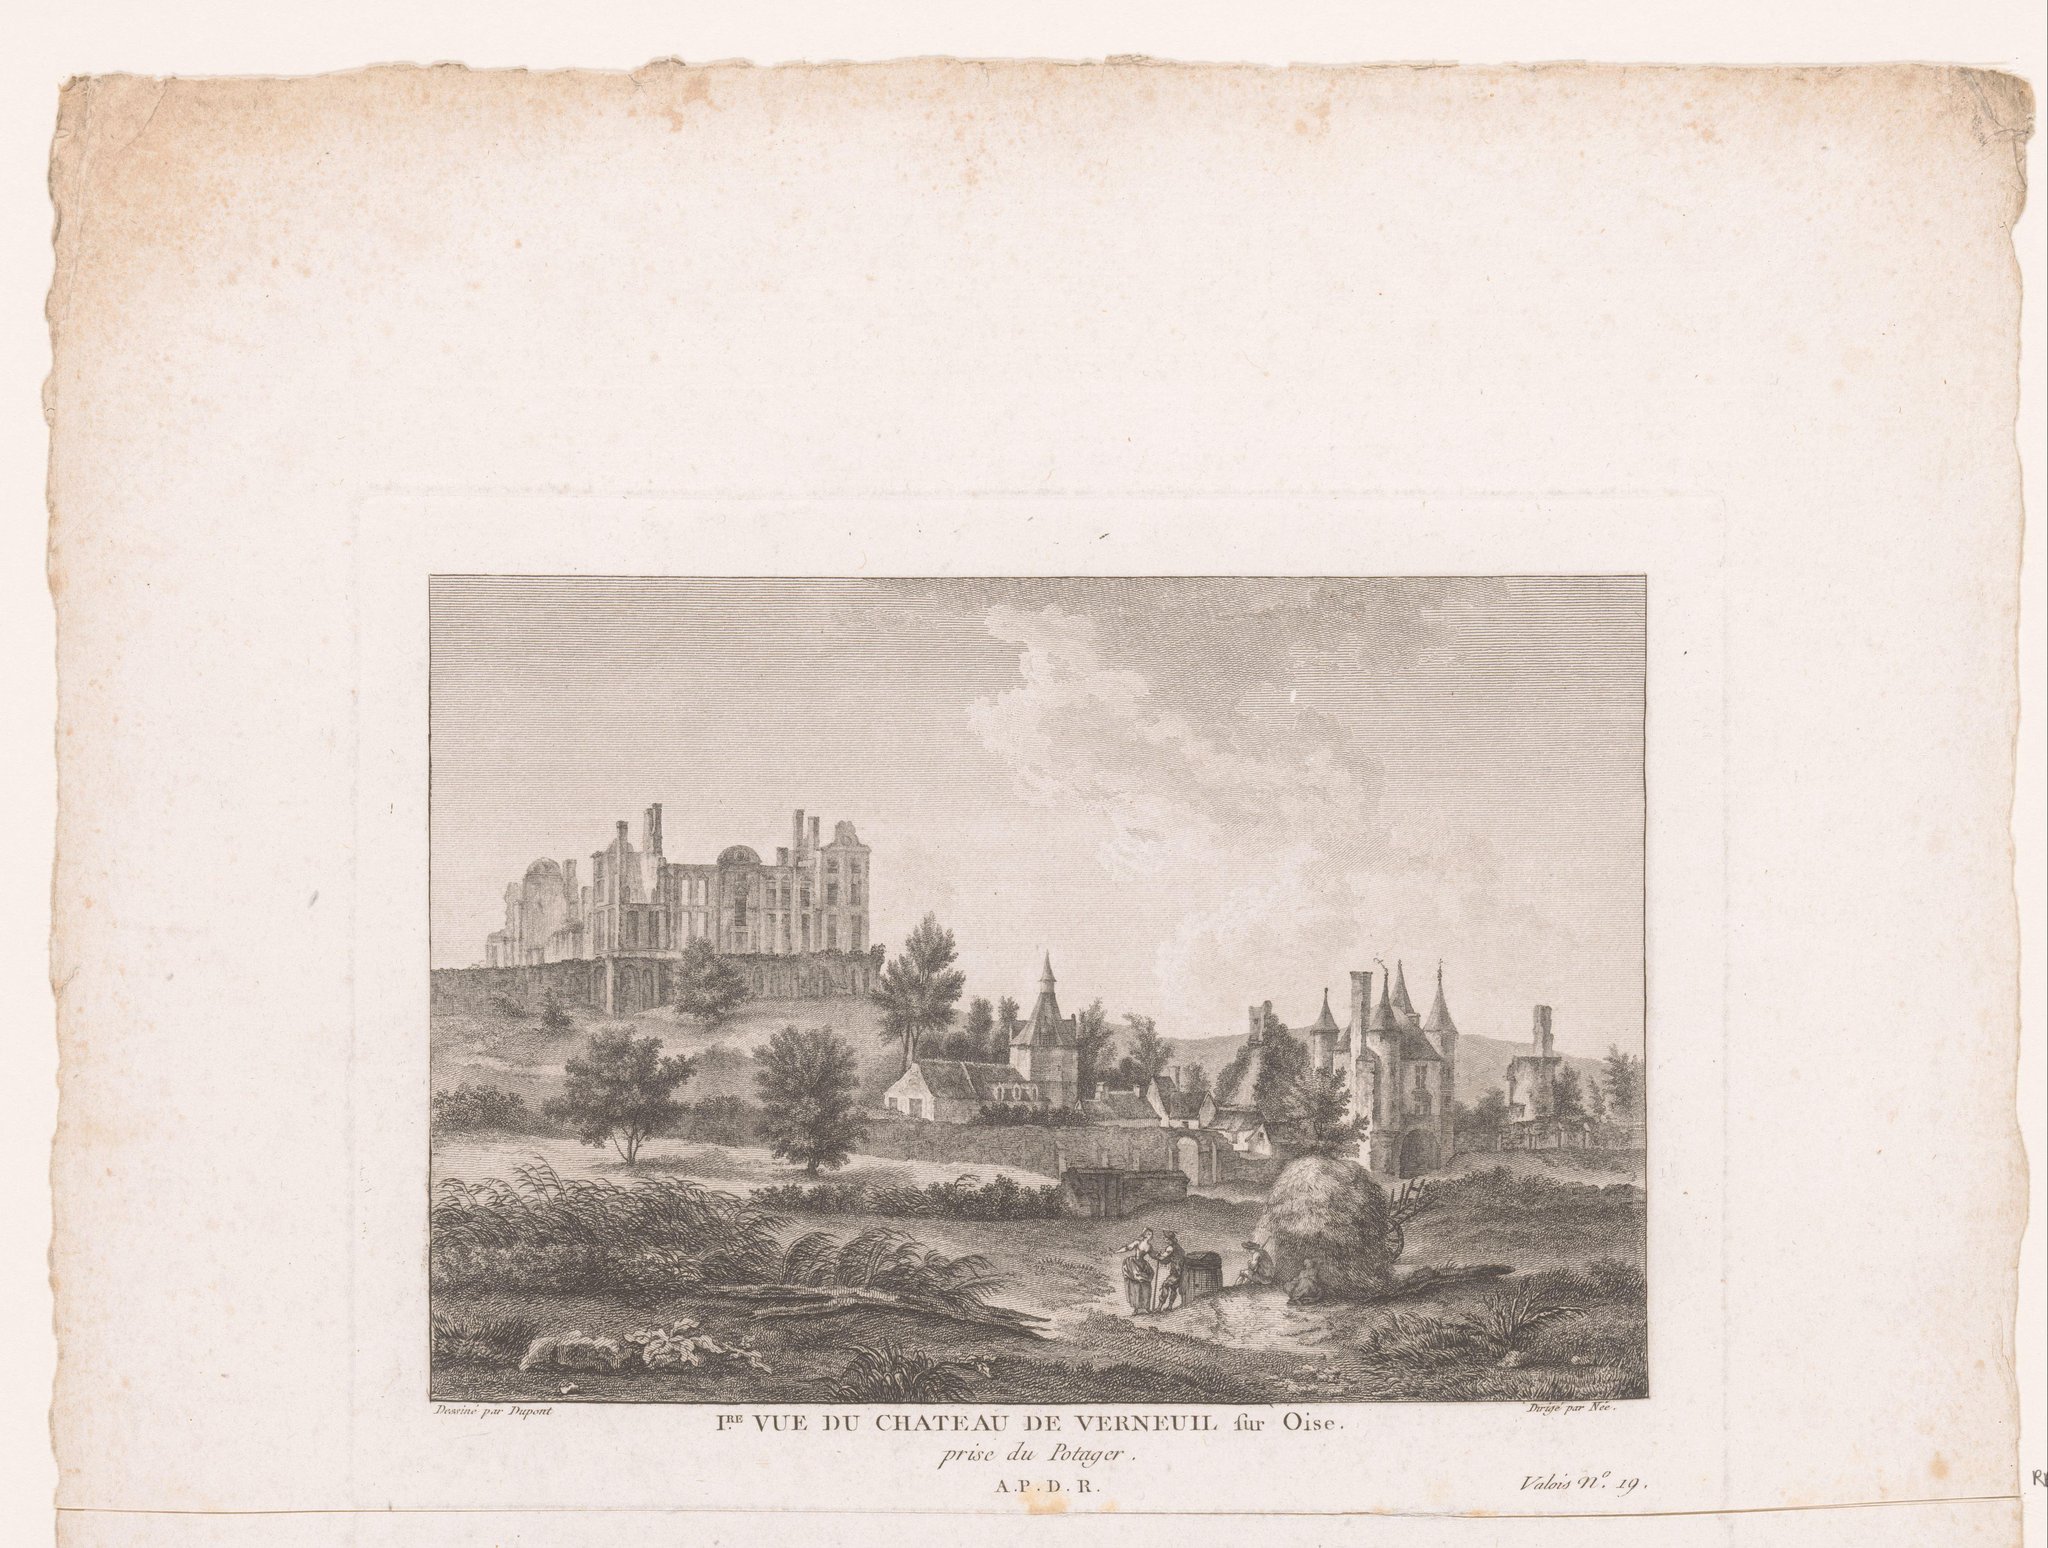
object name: print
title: Ire Vue du chateau de Verneuil sur Oise prise du Potager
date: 1749-1817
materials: paper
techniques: etching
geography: france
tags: landscape with ruins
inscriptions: collector's mark: Lugt 2228